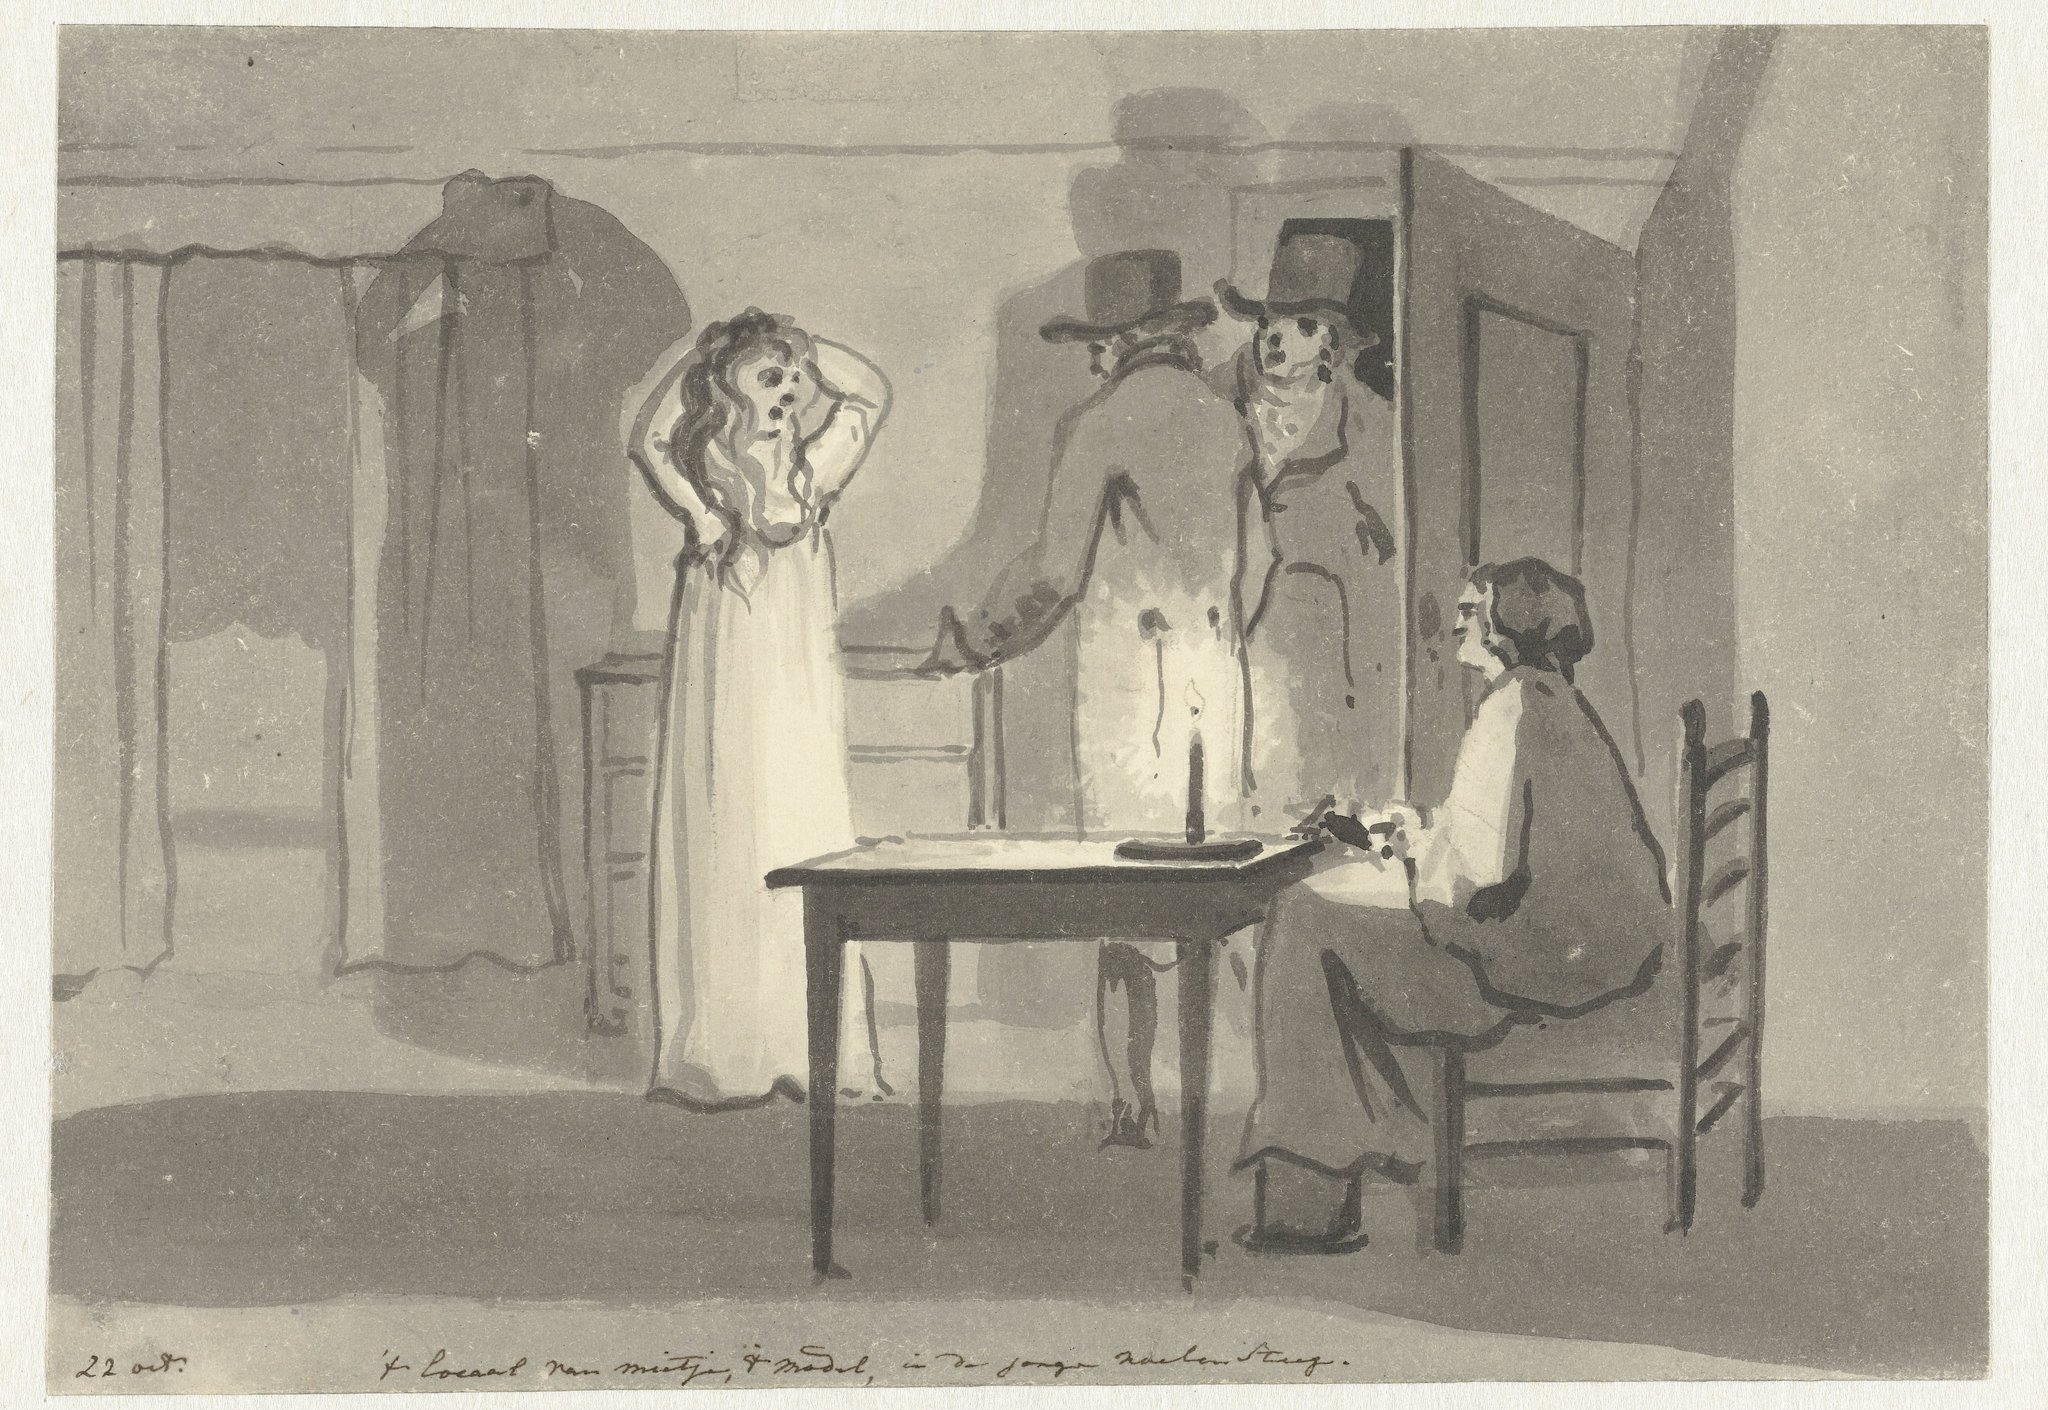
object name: drawing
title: ‘The Premises of Mietje, the Model, at Jonge Roelensteeg’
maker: christiaan andriessen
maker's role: draughtsman, print maker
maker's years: 1775-1846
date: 1805-1808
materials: paper, pencil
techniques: brush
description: Mietje was Andriessen’s regular model. What she did at her ‘premises’ at Jonge Roelensteeg is not known, but people were sometimes caught in this street for indecent behaviour. Mietje could only have been the 25-year-old Maria Bont, who died from a seizure on Friday, 30 September 1808. Andriessen recorded the moment he received notice of this tragedy in a drawing on view elsewhere in this gallery.